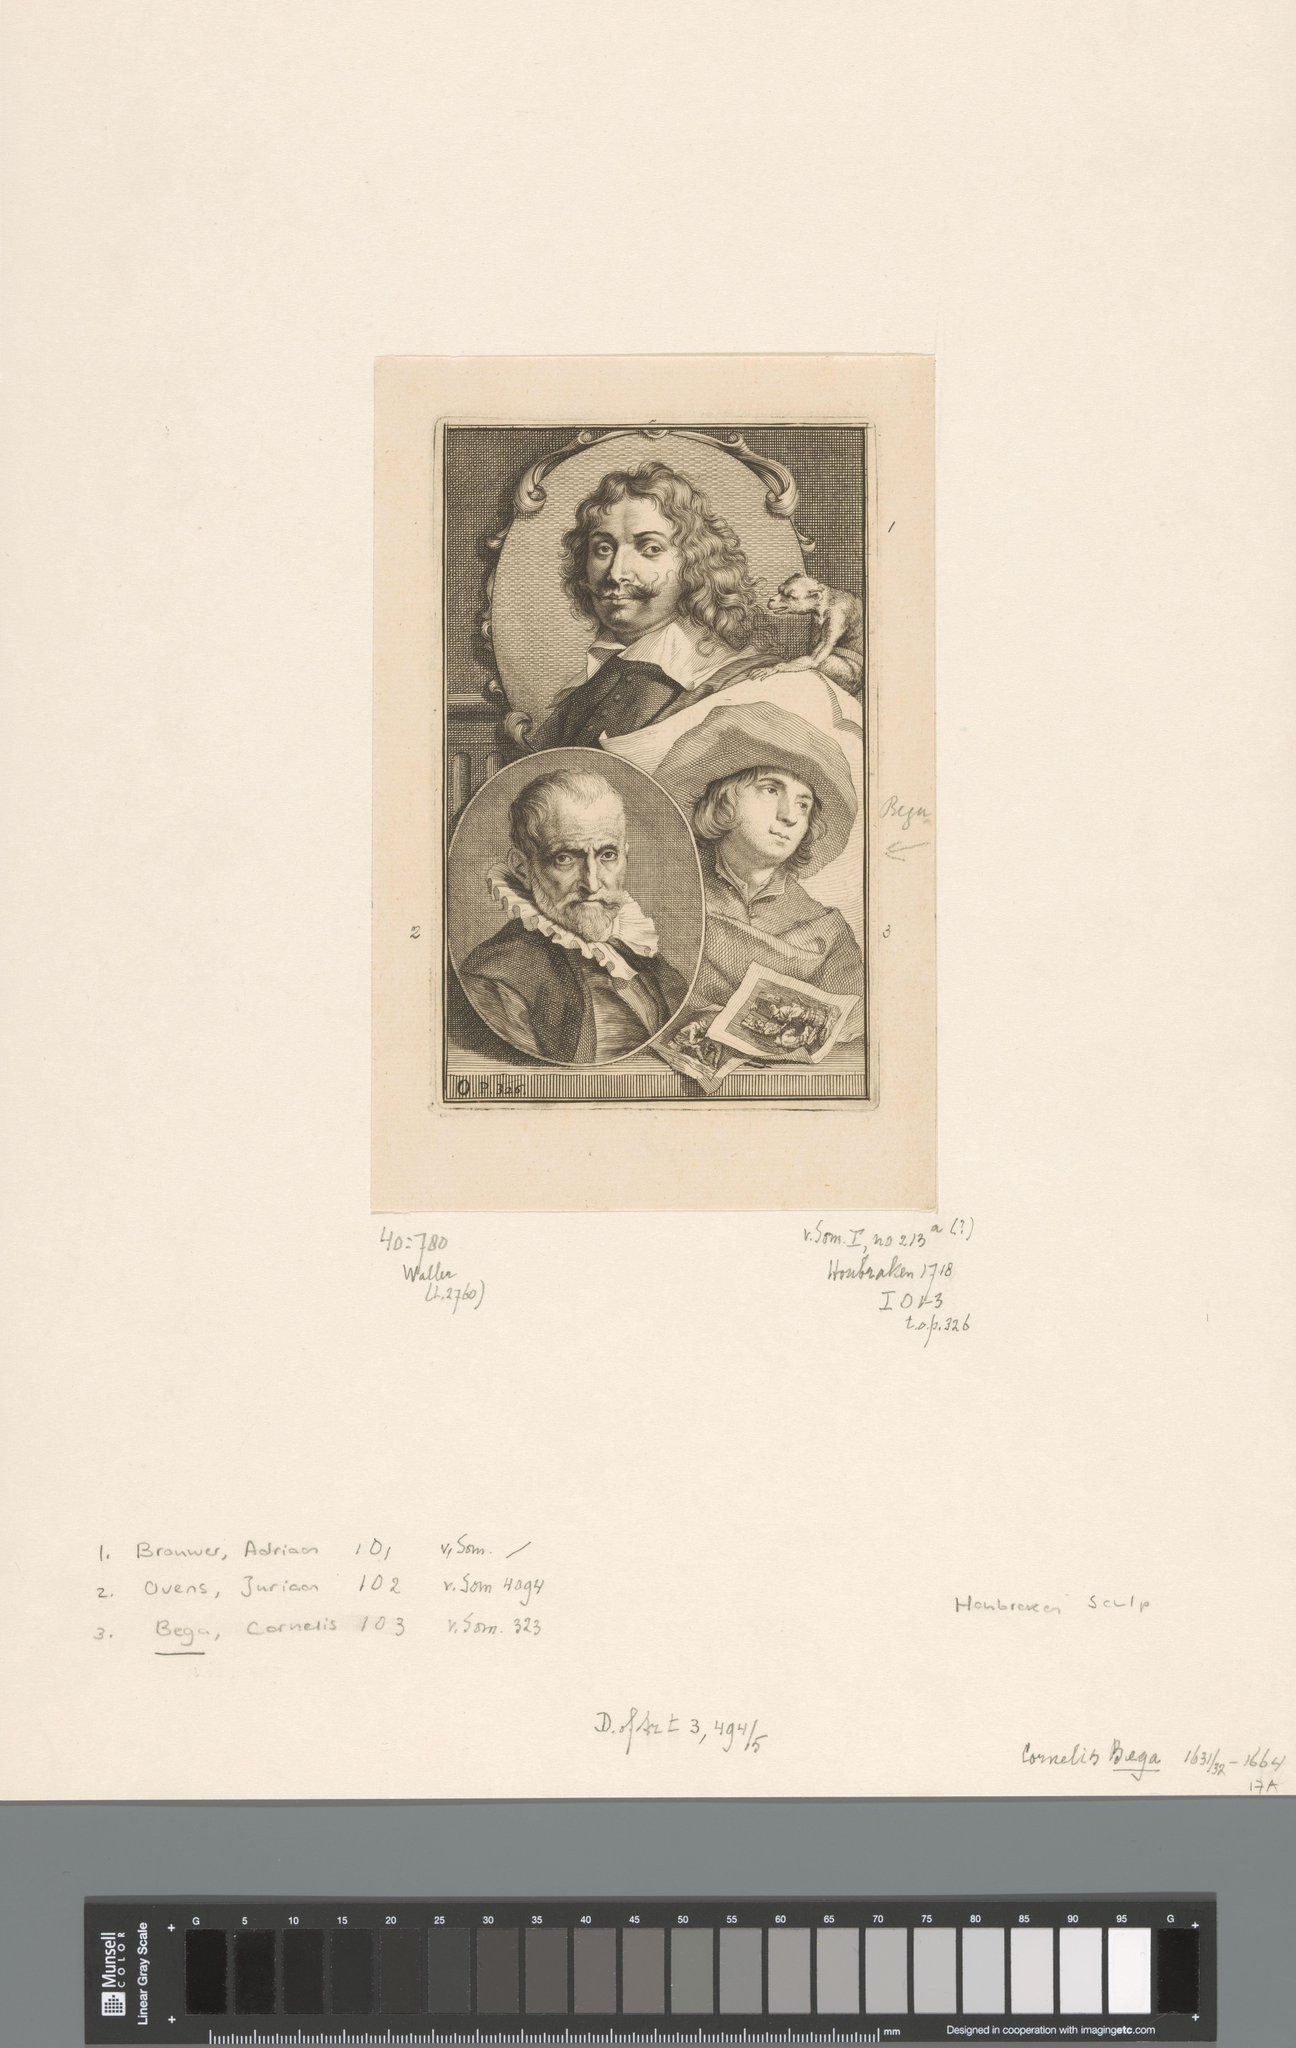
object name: print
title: Portretten van Adriaen Brouwer, Jürgen Ovens en Cornelis Pietersz. Bega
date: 1718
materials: paper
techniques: engraving, etching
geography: amsterdam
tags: painter, print maker, draughtsman, jürgen ovens, antwerp, adriaen brouwer, haarlem, cornelis pietersz. bega, historical persons, portrait, self-portrait of painter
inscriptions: collector's mark: Lugt 2228, collector's mark: Lugt 2760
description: Prent uit: Houbraken, Arnold. De groote schouburgh der Nederlantsche konstschilders en schilderessen (...). Amsterdam: Arnold Houbraken, 1718, dl. 1.